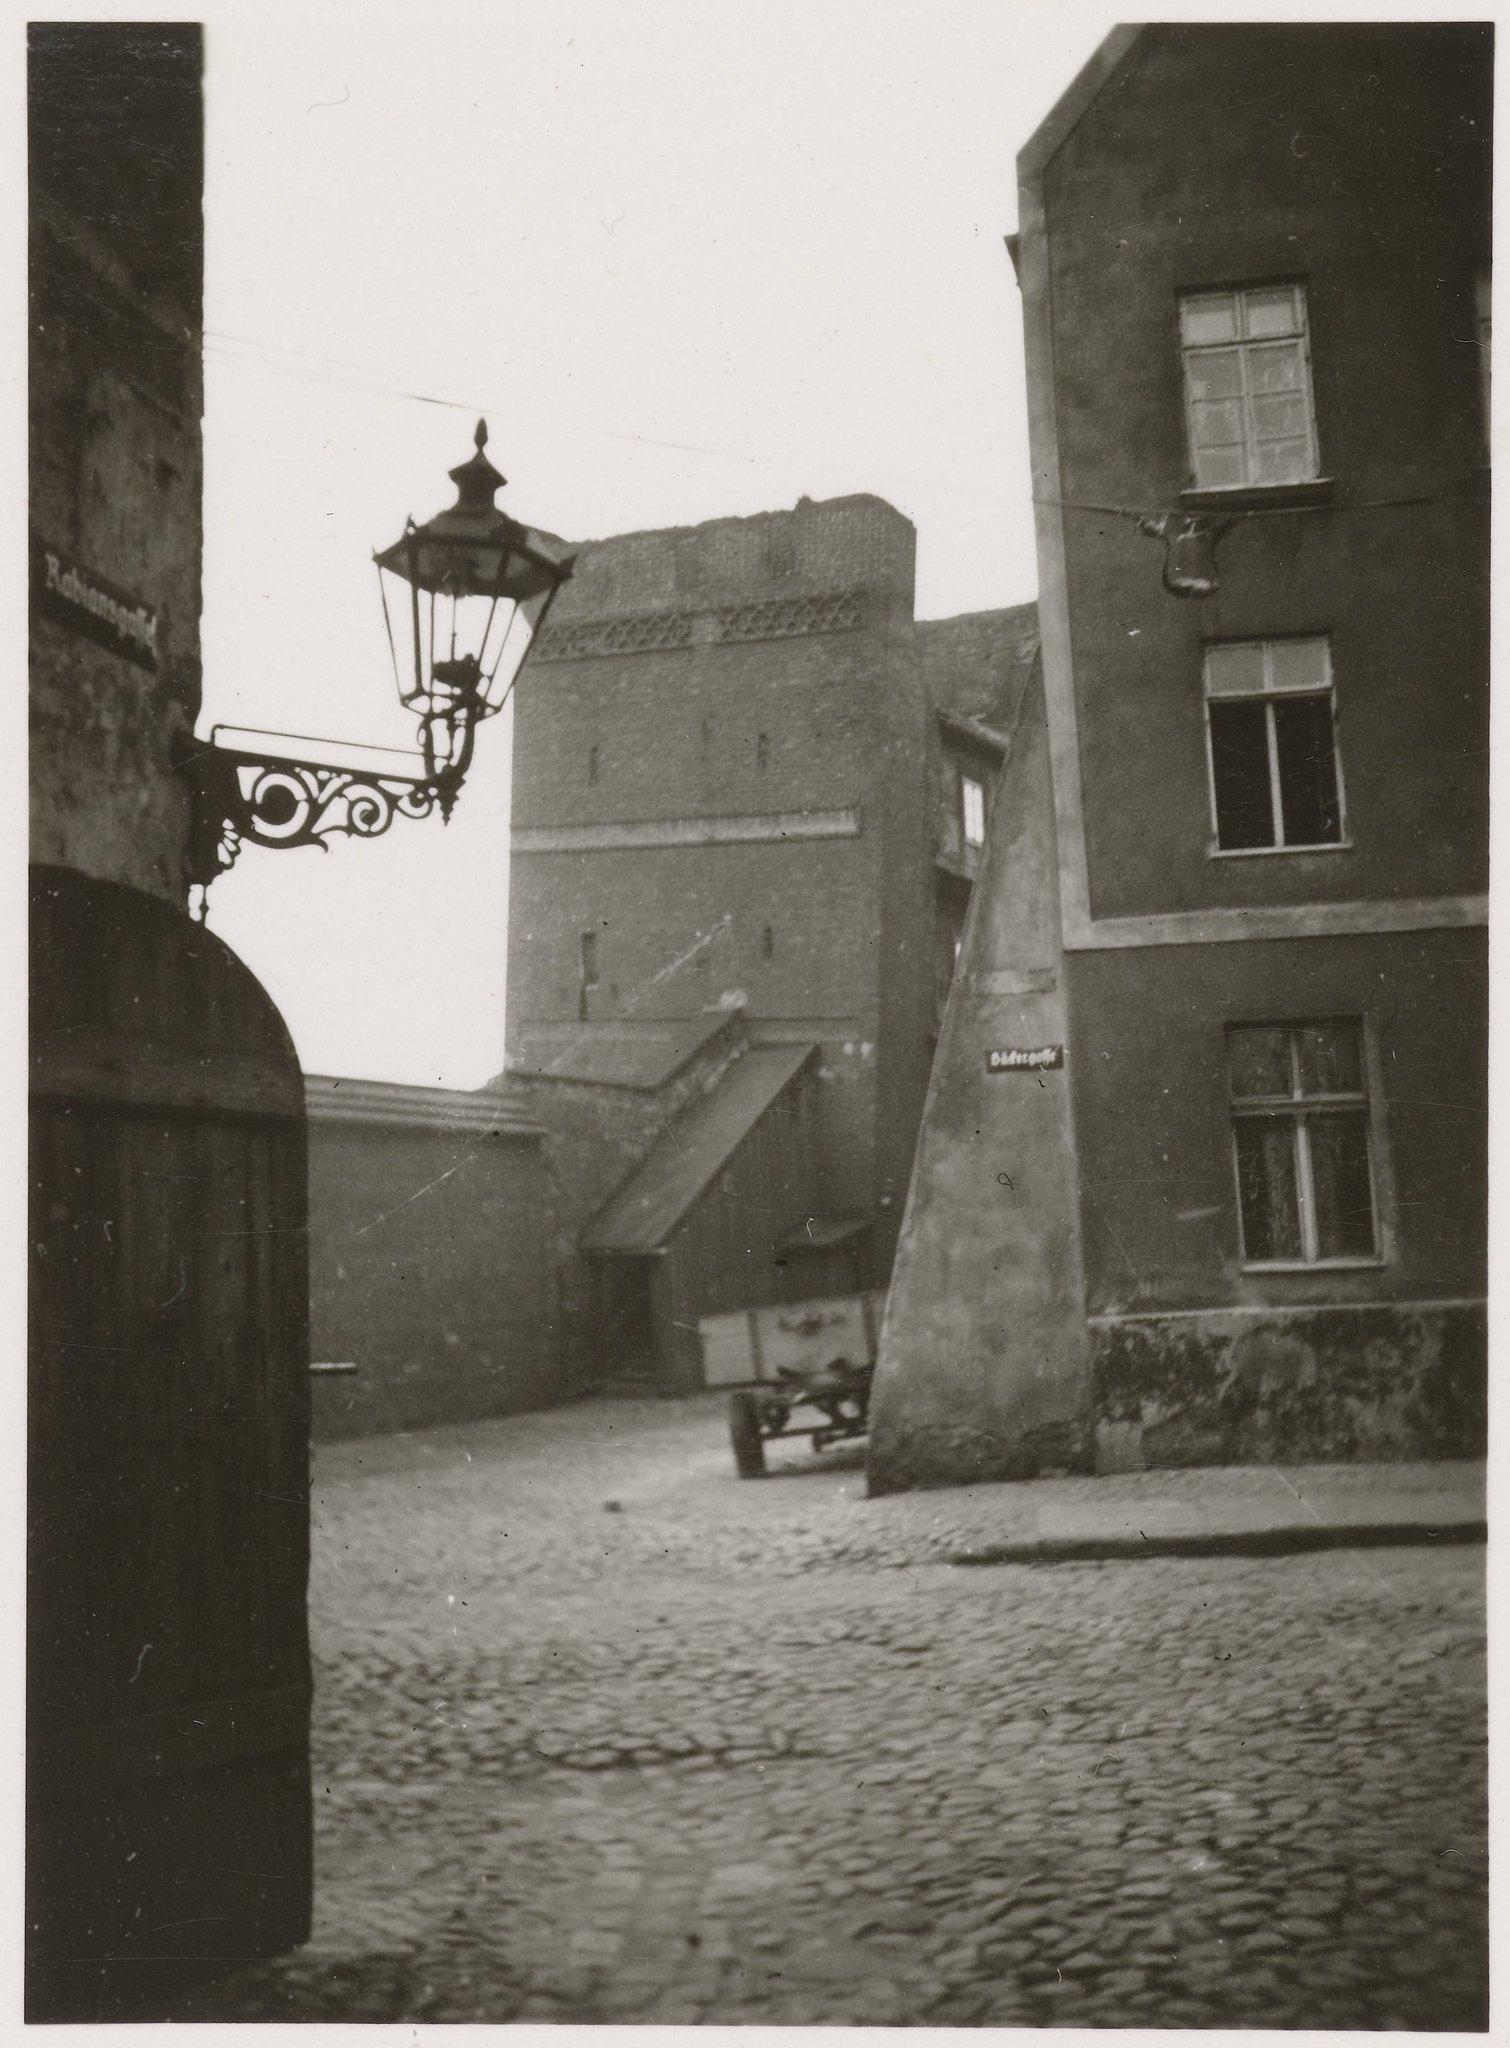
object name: photograph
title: Een straat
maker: Anonymous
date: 1940-1945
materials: photographic support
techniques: gelatin silver print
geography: france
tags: netherlands, germany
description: Een straat met huizen en een muur. Links een lantaarn. Duitse tekst achterop. Foto behorend bij album 'Kriegserinnerungen'.